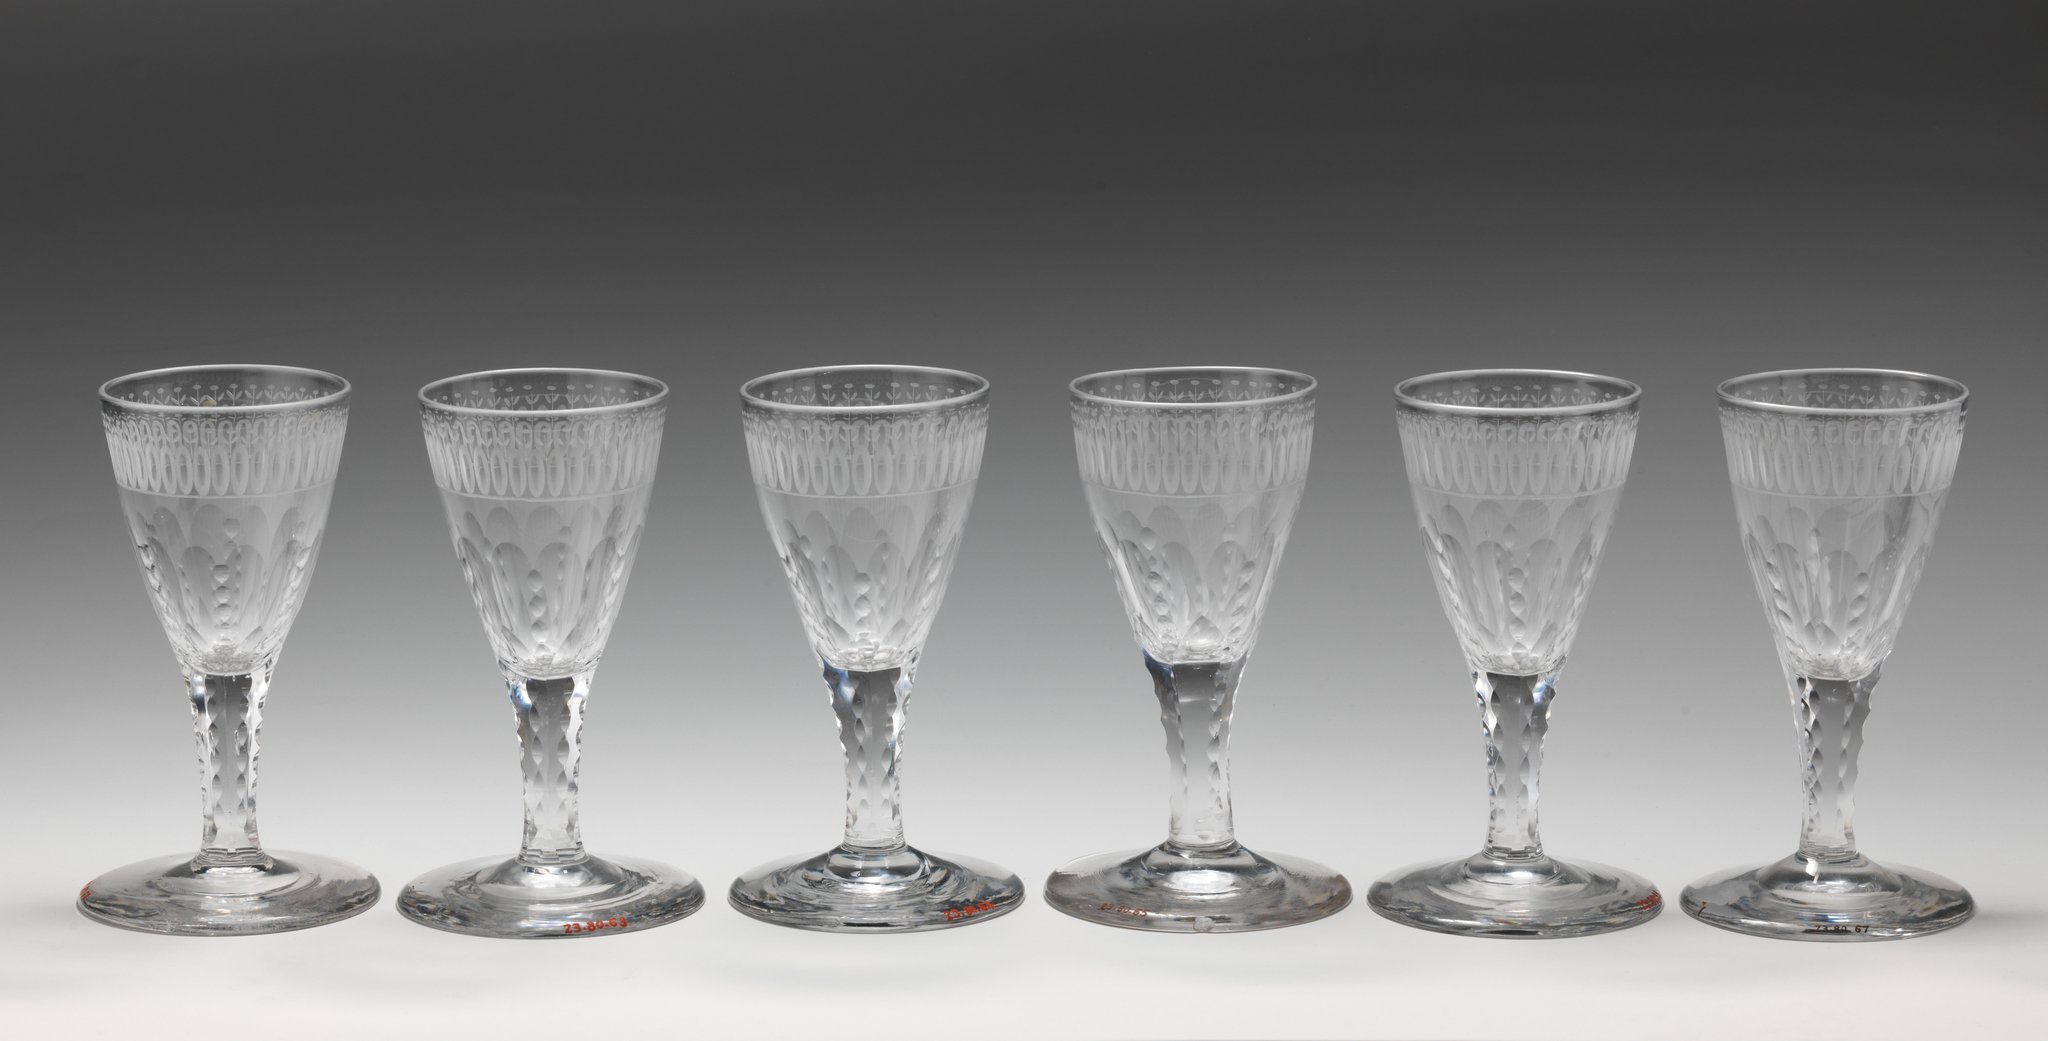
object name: wine or cordial glass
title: Wine or cordial glasses (set of six)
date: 1767-1800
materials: glass